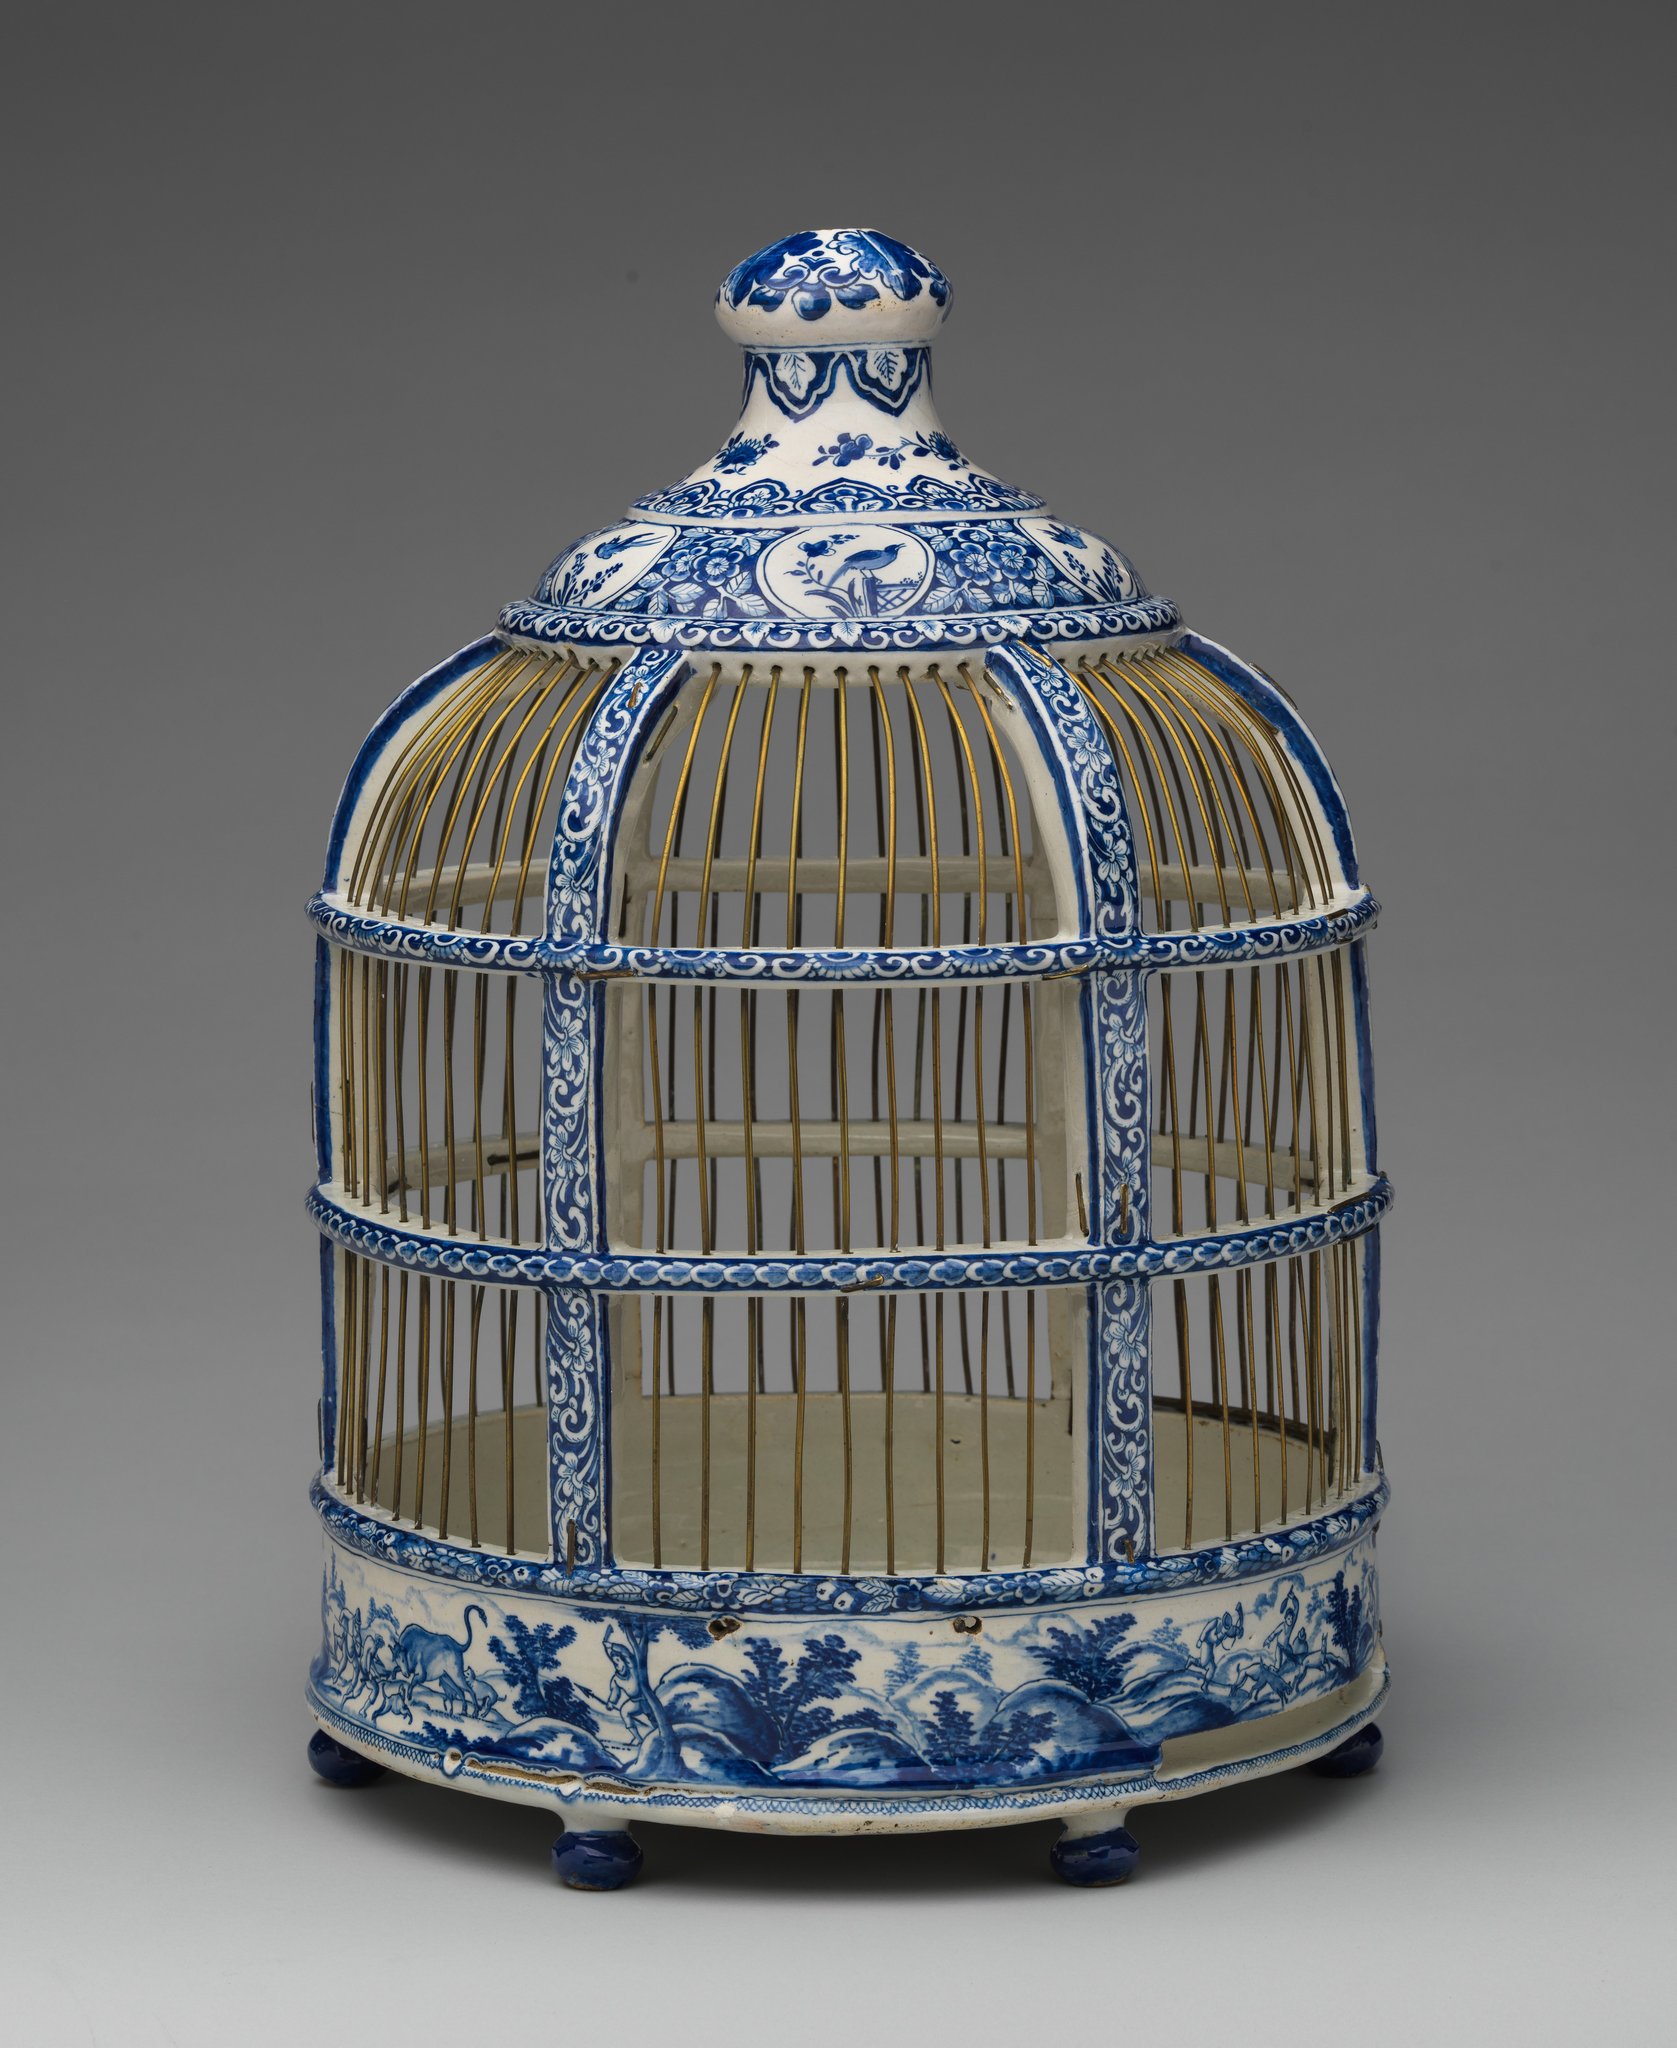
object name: birdcage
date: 1701-1750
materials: earthenware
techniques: glazing